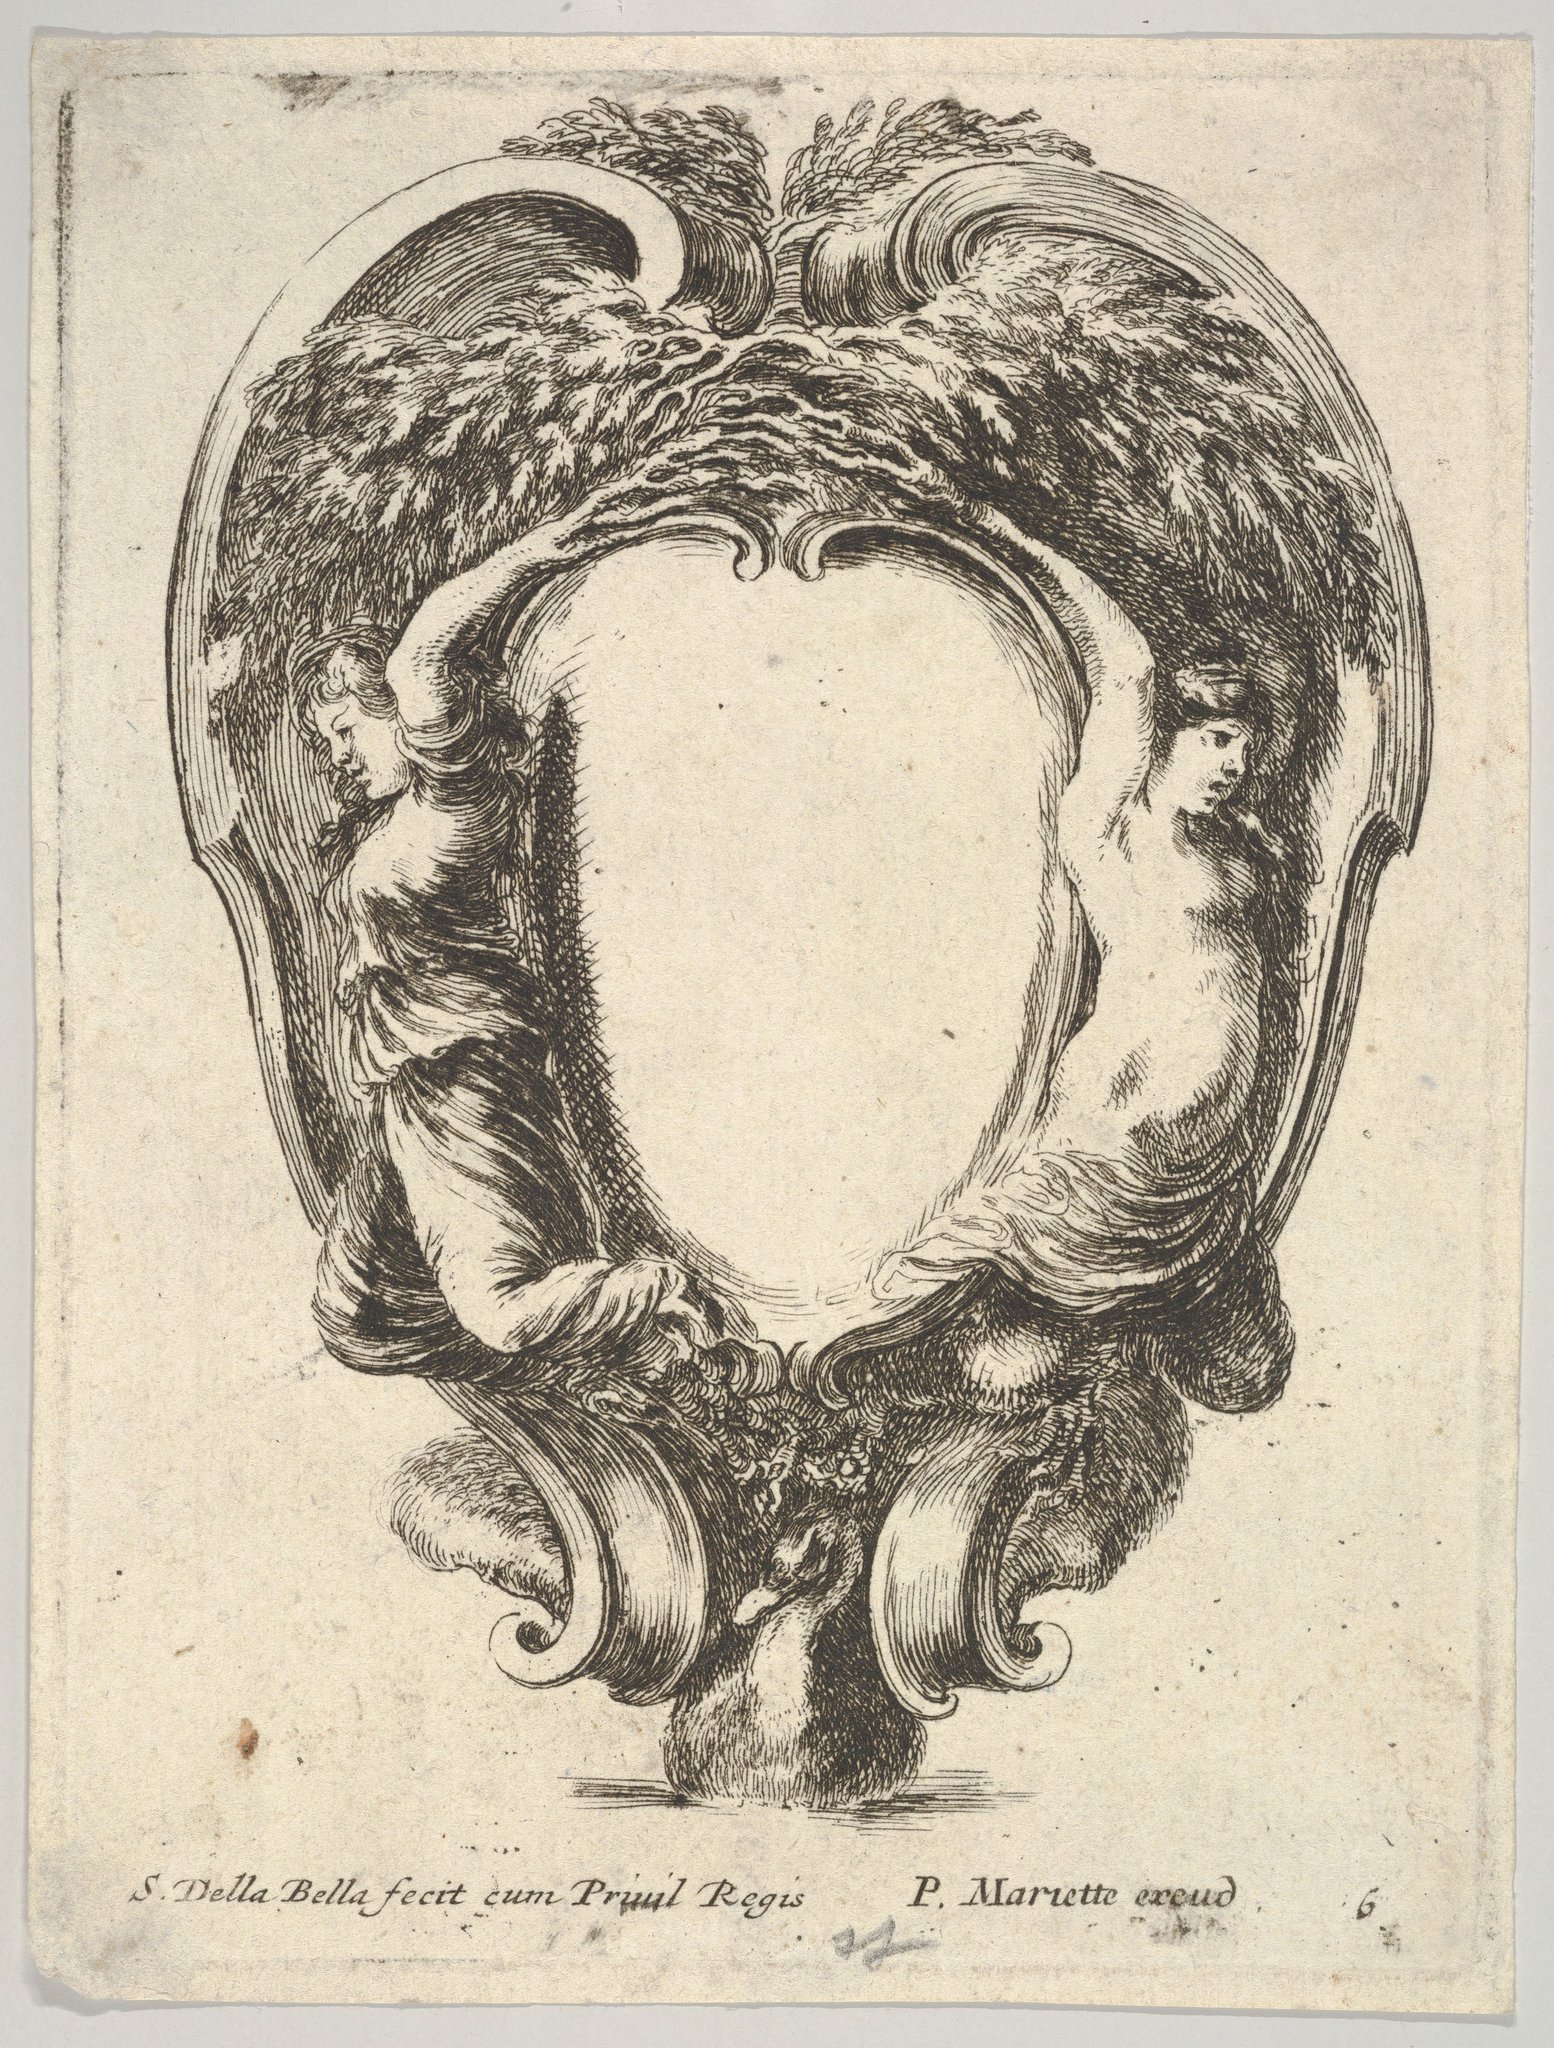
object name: print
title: A cartouche supported by a duck below and decorated with two nymphs whose arms become tree branches, plate 6 from "Nouvelles inventions de Cartouches"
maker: stefano della bella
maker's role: artist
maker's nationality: italian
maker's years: 1610-1664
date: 1647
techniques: etching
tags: ducks,cartouches,nymphs